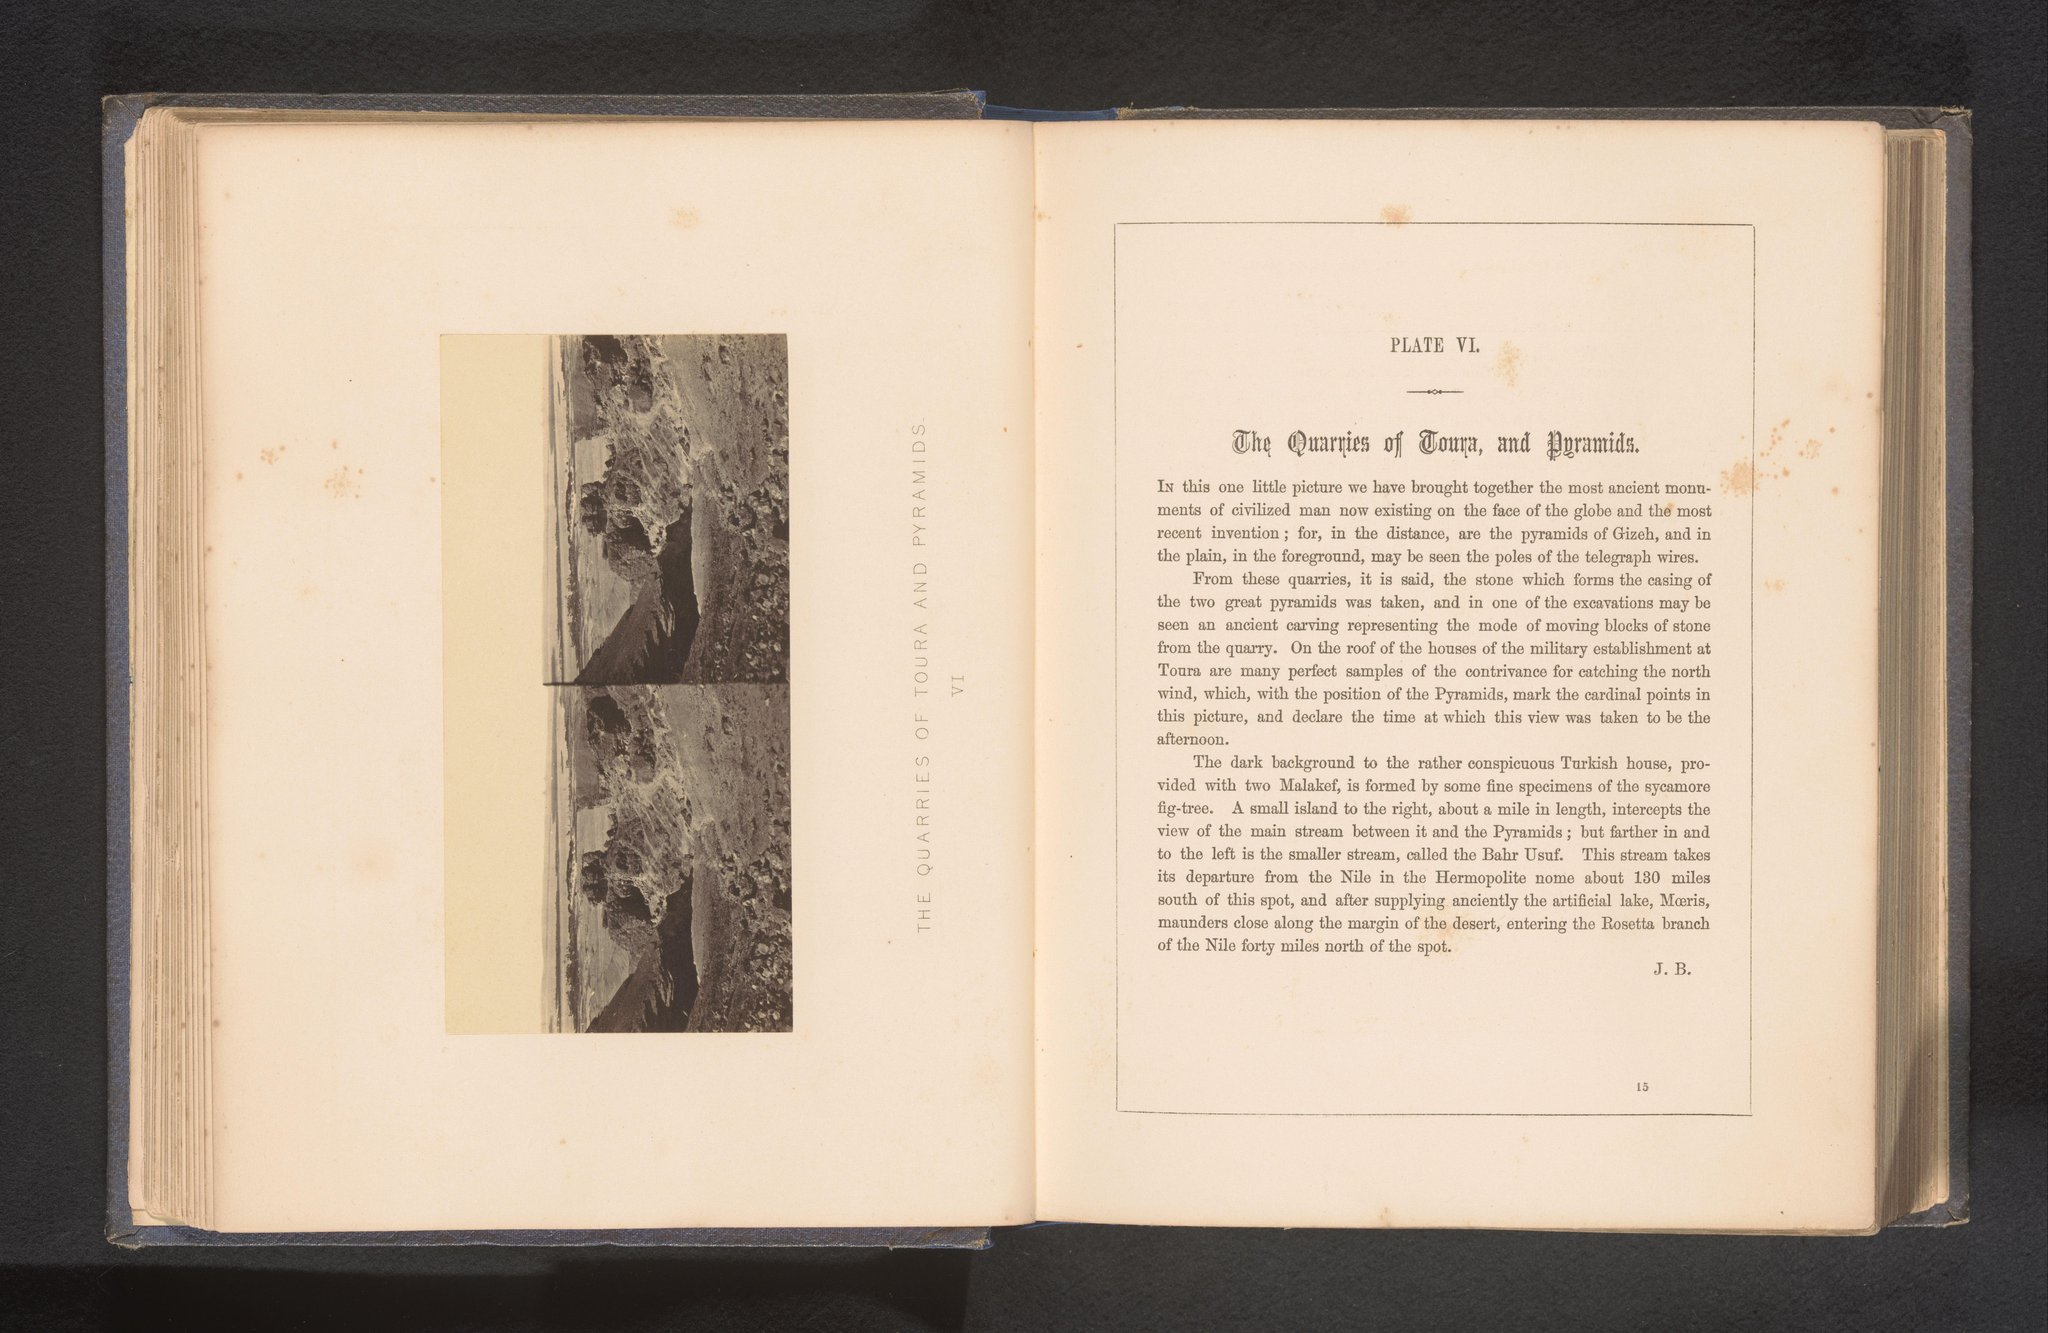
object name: page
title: The quarries of toura and pyramids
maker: francis frith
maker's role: publisher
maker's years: 1822-1898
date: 1857-1862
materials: photographic support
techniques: albumen print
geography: gizeh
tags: quarry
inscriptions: number: ‘VI’